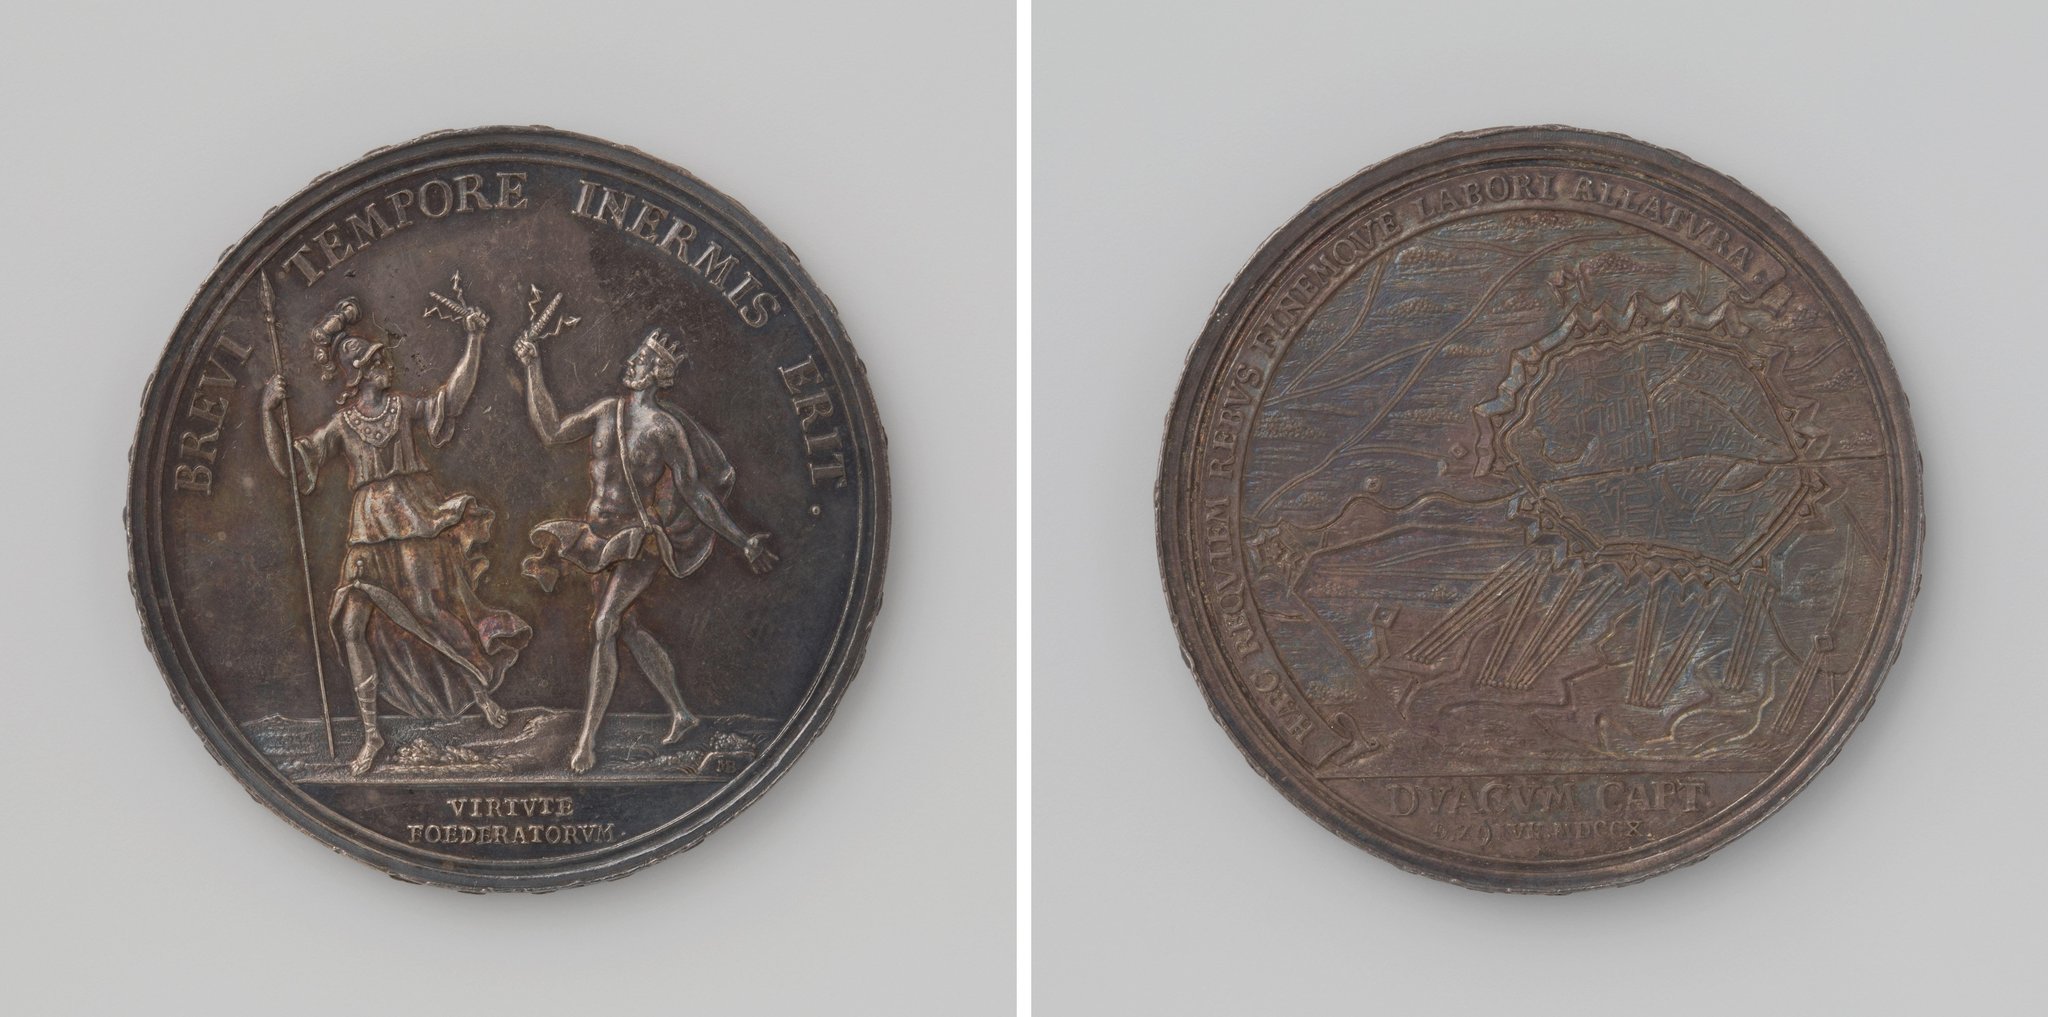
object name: history medal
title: Inname van Douai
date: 1710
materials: silver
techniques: striking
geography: nuremberg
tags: nord, douai, inname van douai (1710)